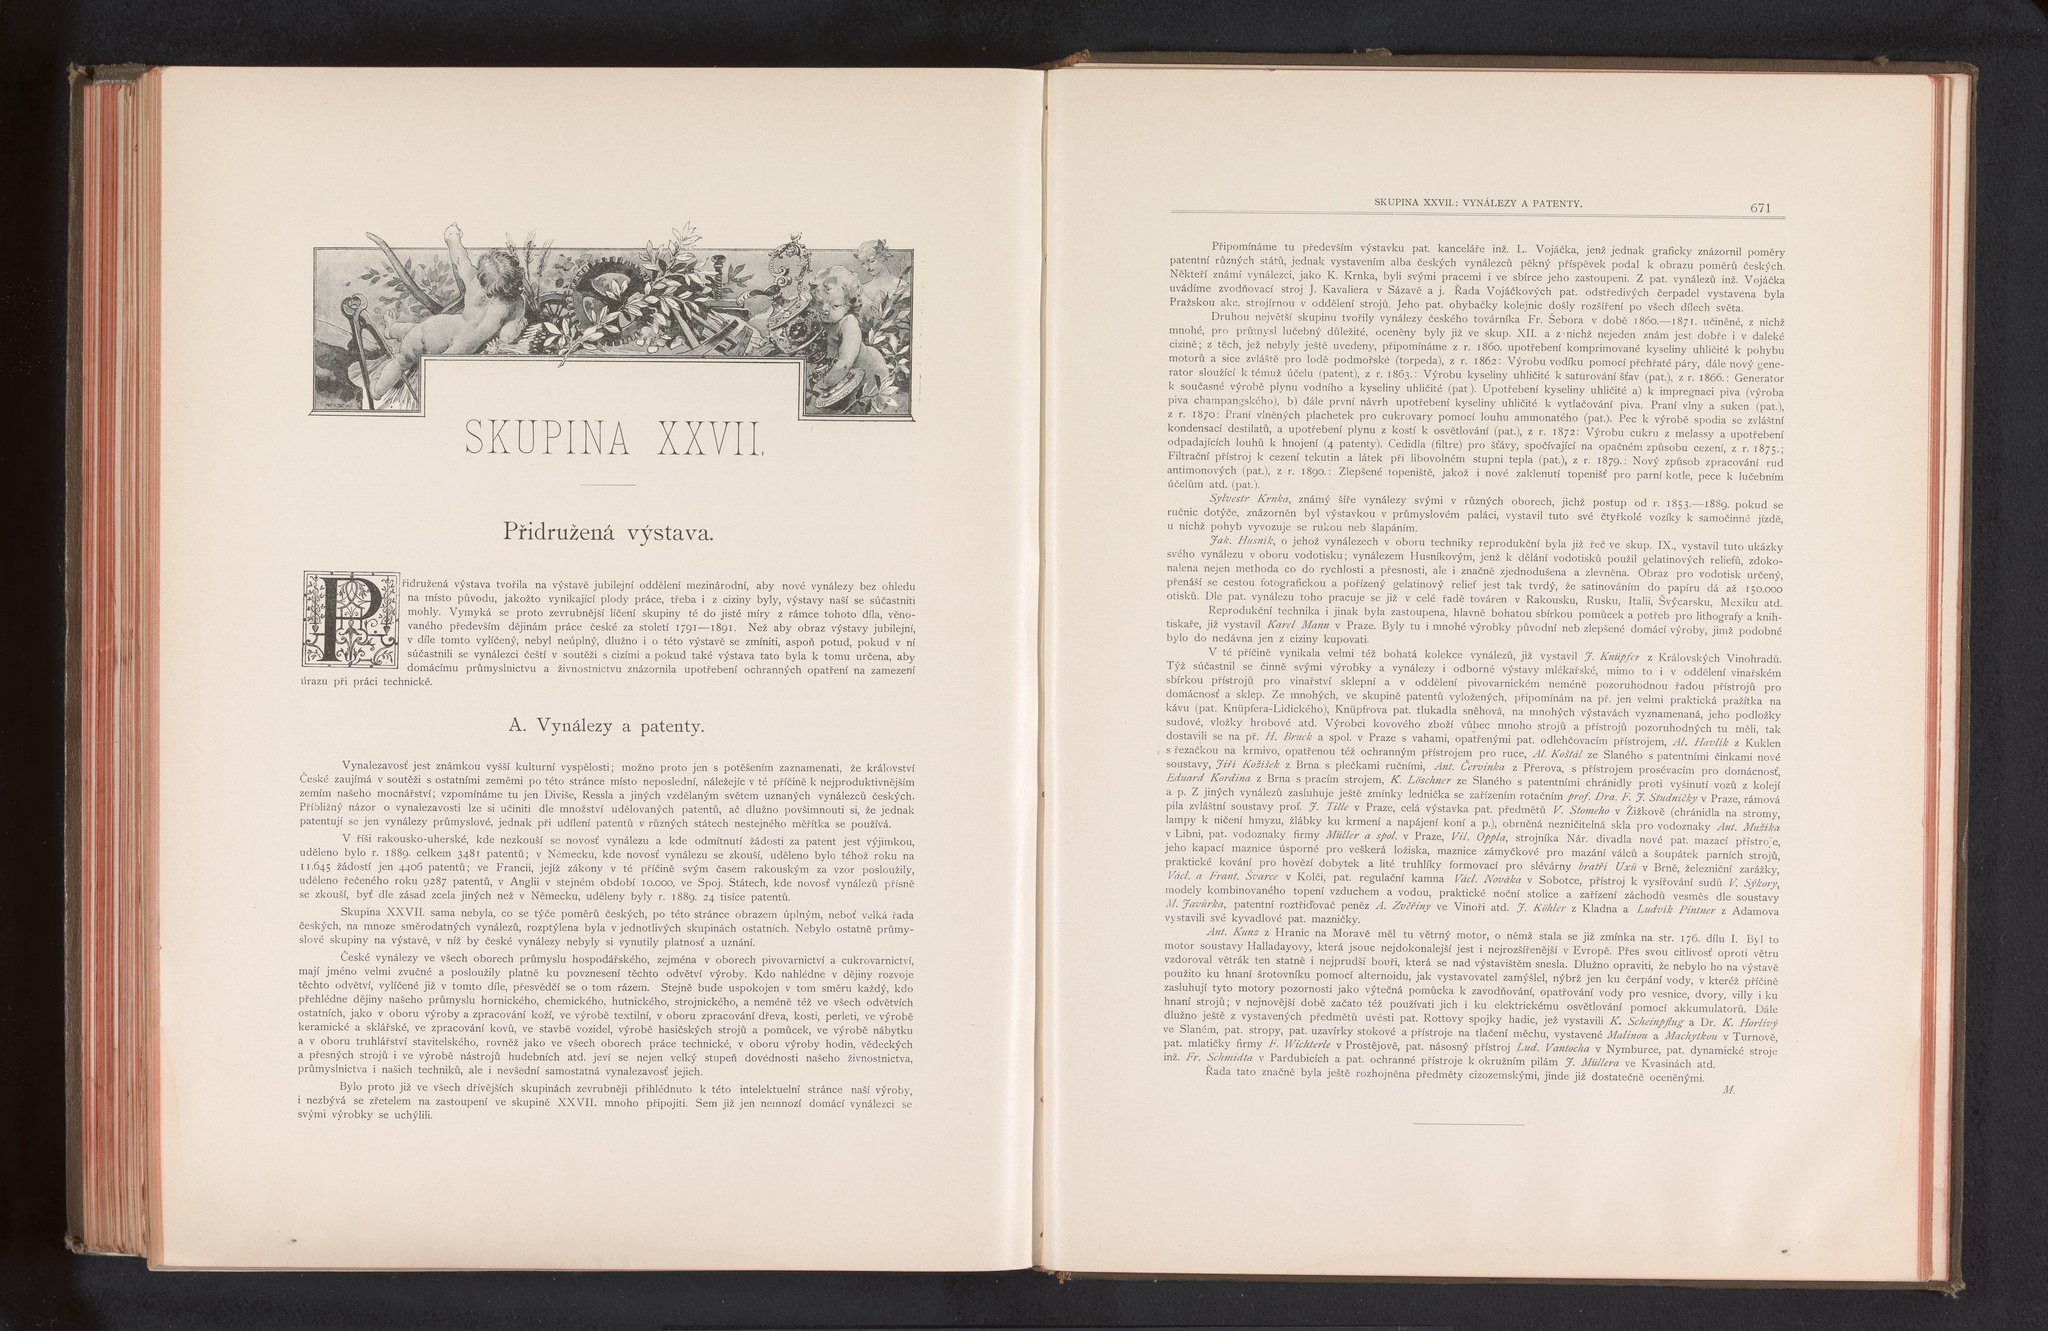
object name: page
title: Fotoreproductie van een tekening, voorstellende putti tussen werktuigen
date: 1891-1895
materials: paper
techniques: autotype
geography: prague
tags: tools, aids, implements ~ crafts and industries, cupids: 'amores', 'amoretti', 'putti'